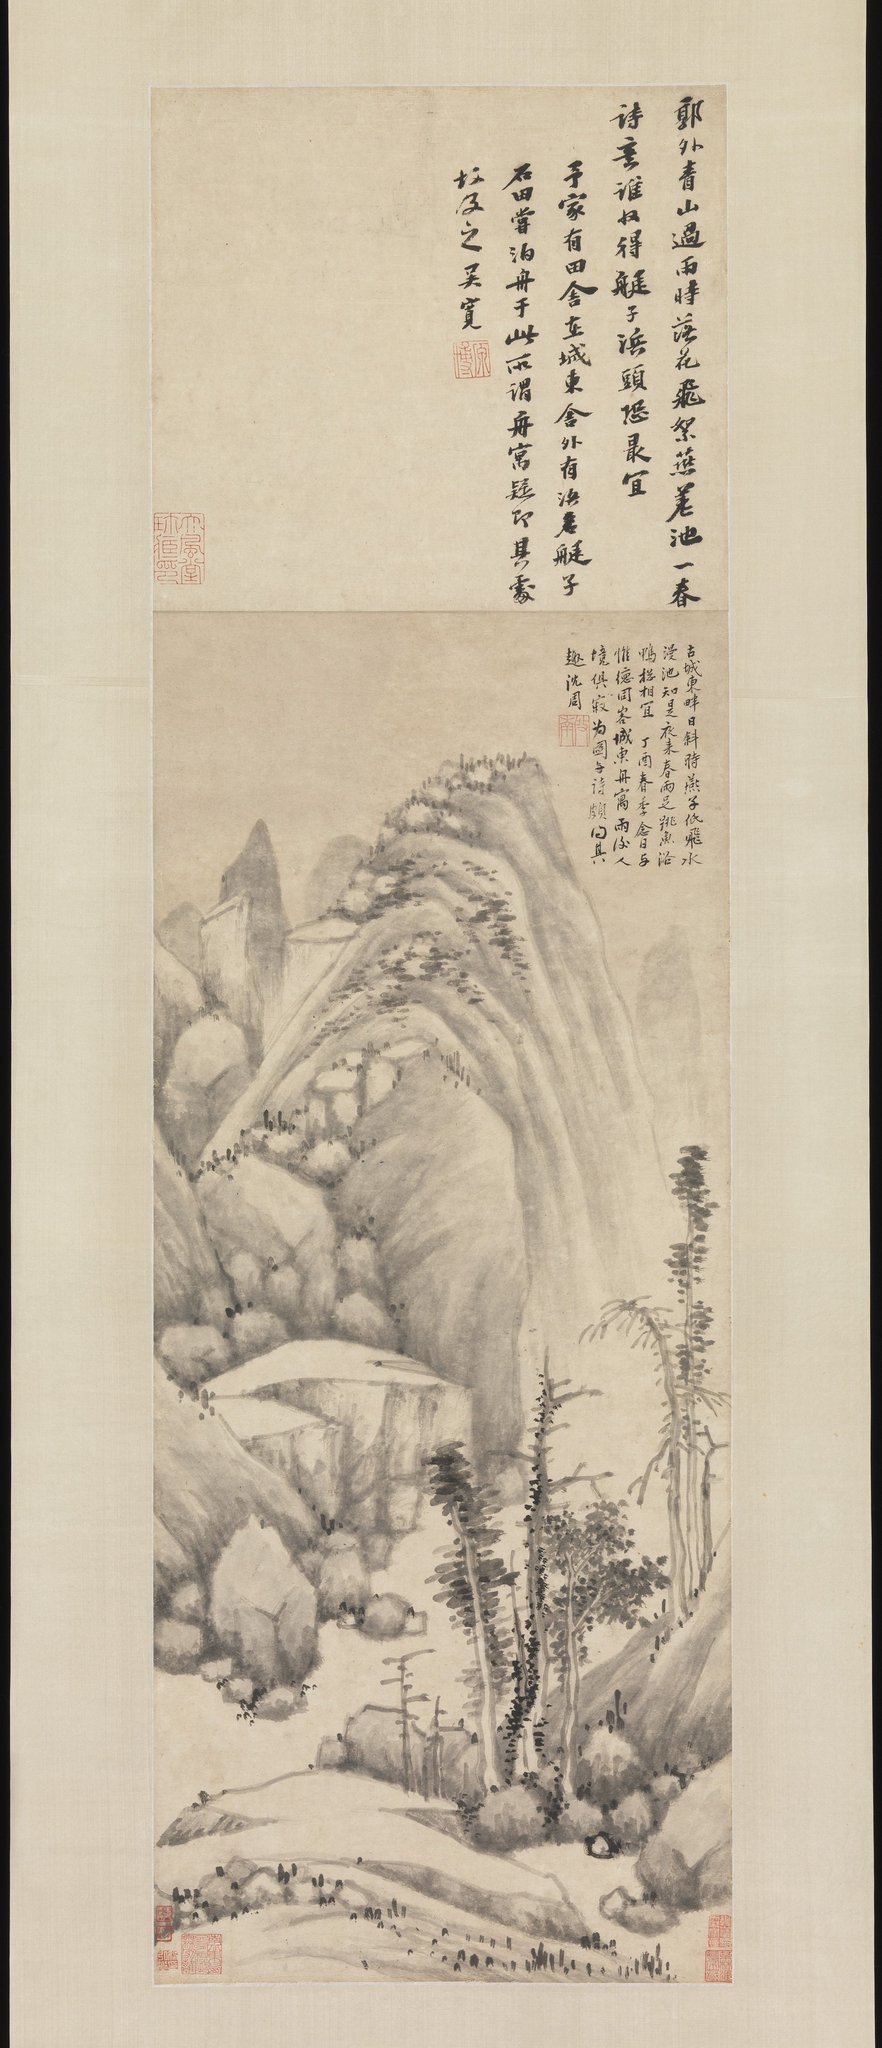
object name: hanging scroll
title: Anchorage on a rainy night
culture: chinese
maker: shen zhou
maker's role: artist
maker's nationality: chinese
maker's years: 1427-1509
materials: ink, paper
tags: mountains,landscapes